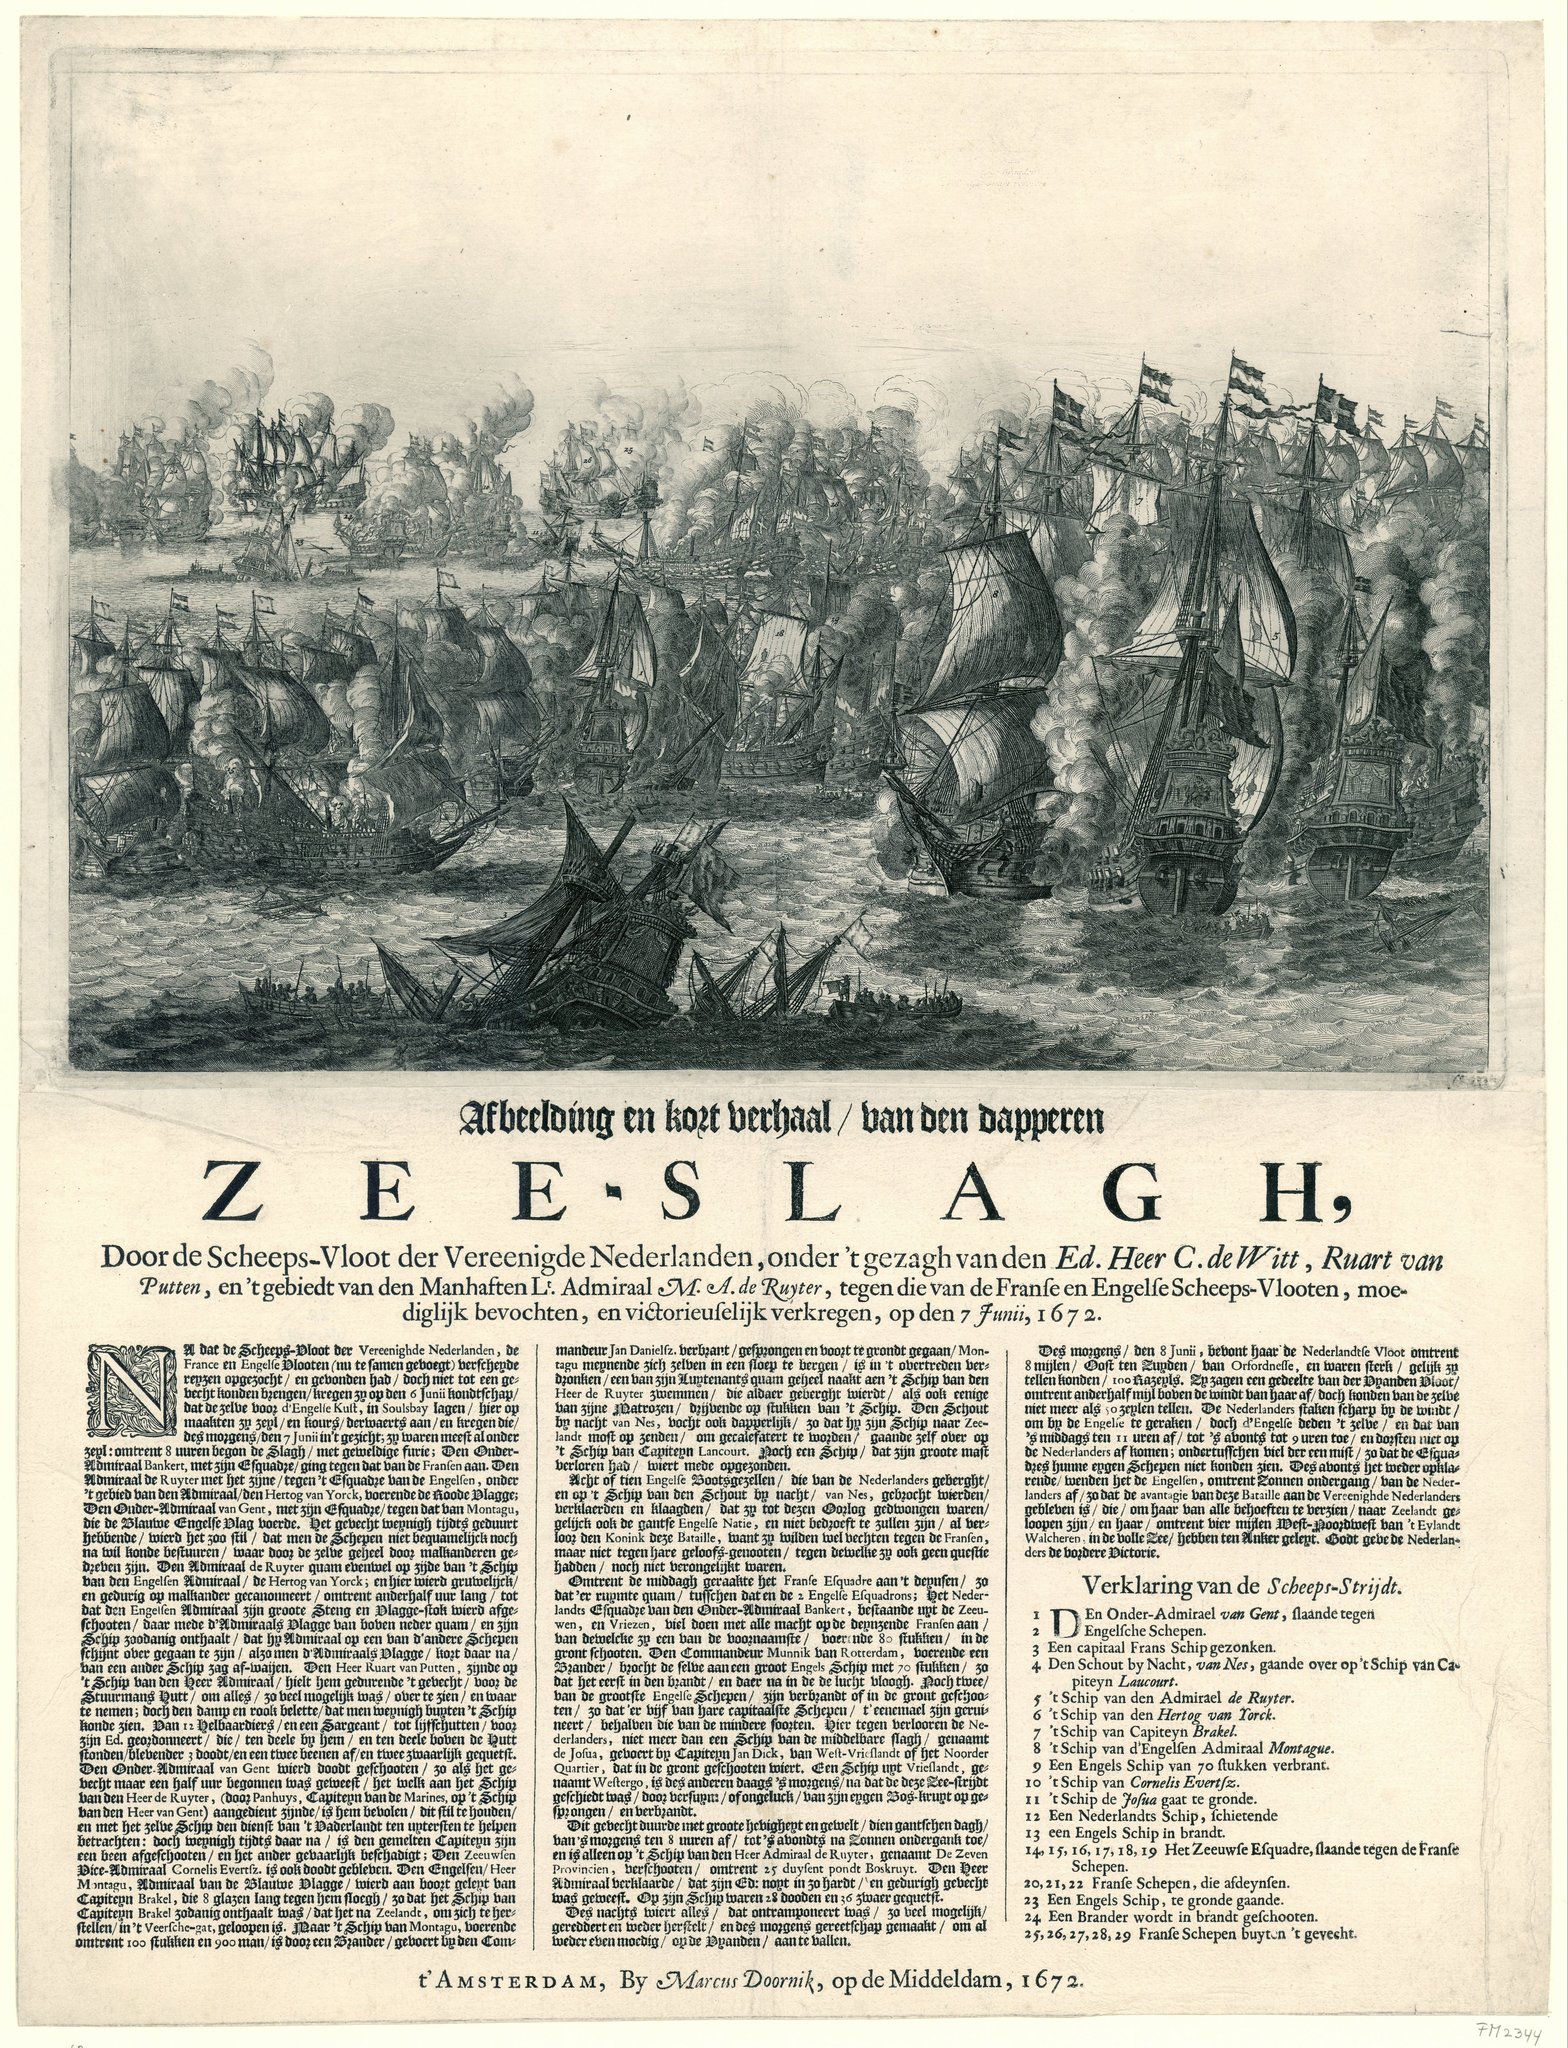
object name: print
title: Slag bij Solebay, 7 juni 1672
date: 1672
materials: paper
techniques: etching, letterpress printing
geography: amsterdam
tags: flushing, michiel adriaenszoon de ruyter, jacobus ii (koning van engeland en schotland), battle (+ naval force), battle of solebay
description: De slag bij Solebay op 7 juni 1672 tussen de Staatse vloot onder Michiel Adriaenszoon de Ruyter en de Engels-Franse vloot onder de hertog van York en de vice-admiraal Jean II d'Estrees. Onder de voorstelling is een blad geplakt met een beschrijving van de gebeurtenissen in drie kolommen. Op het eind van de tekst staat een verklaring van de voorstelling waarin de individuele schepen worden geïdentificeerd. De prent is gedrukt van een plaat die oorspronkelijk vervaardigd is in 1666 voor een voorstelling van de Vierdaagse Zeeslag tussen de Nederlanders en Engelsen op 11-14 juni 1666 (FMH 2234). De plaat is niet veel veranderd, alleen de drie portretten die boven de schepen stonden zijn nu verwijderd.